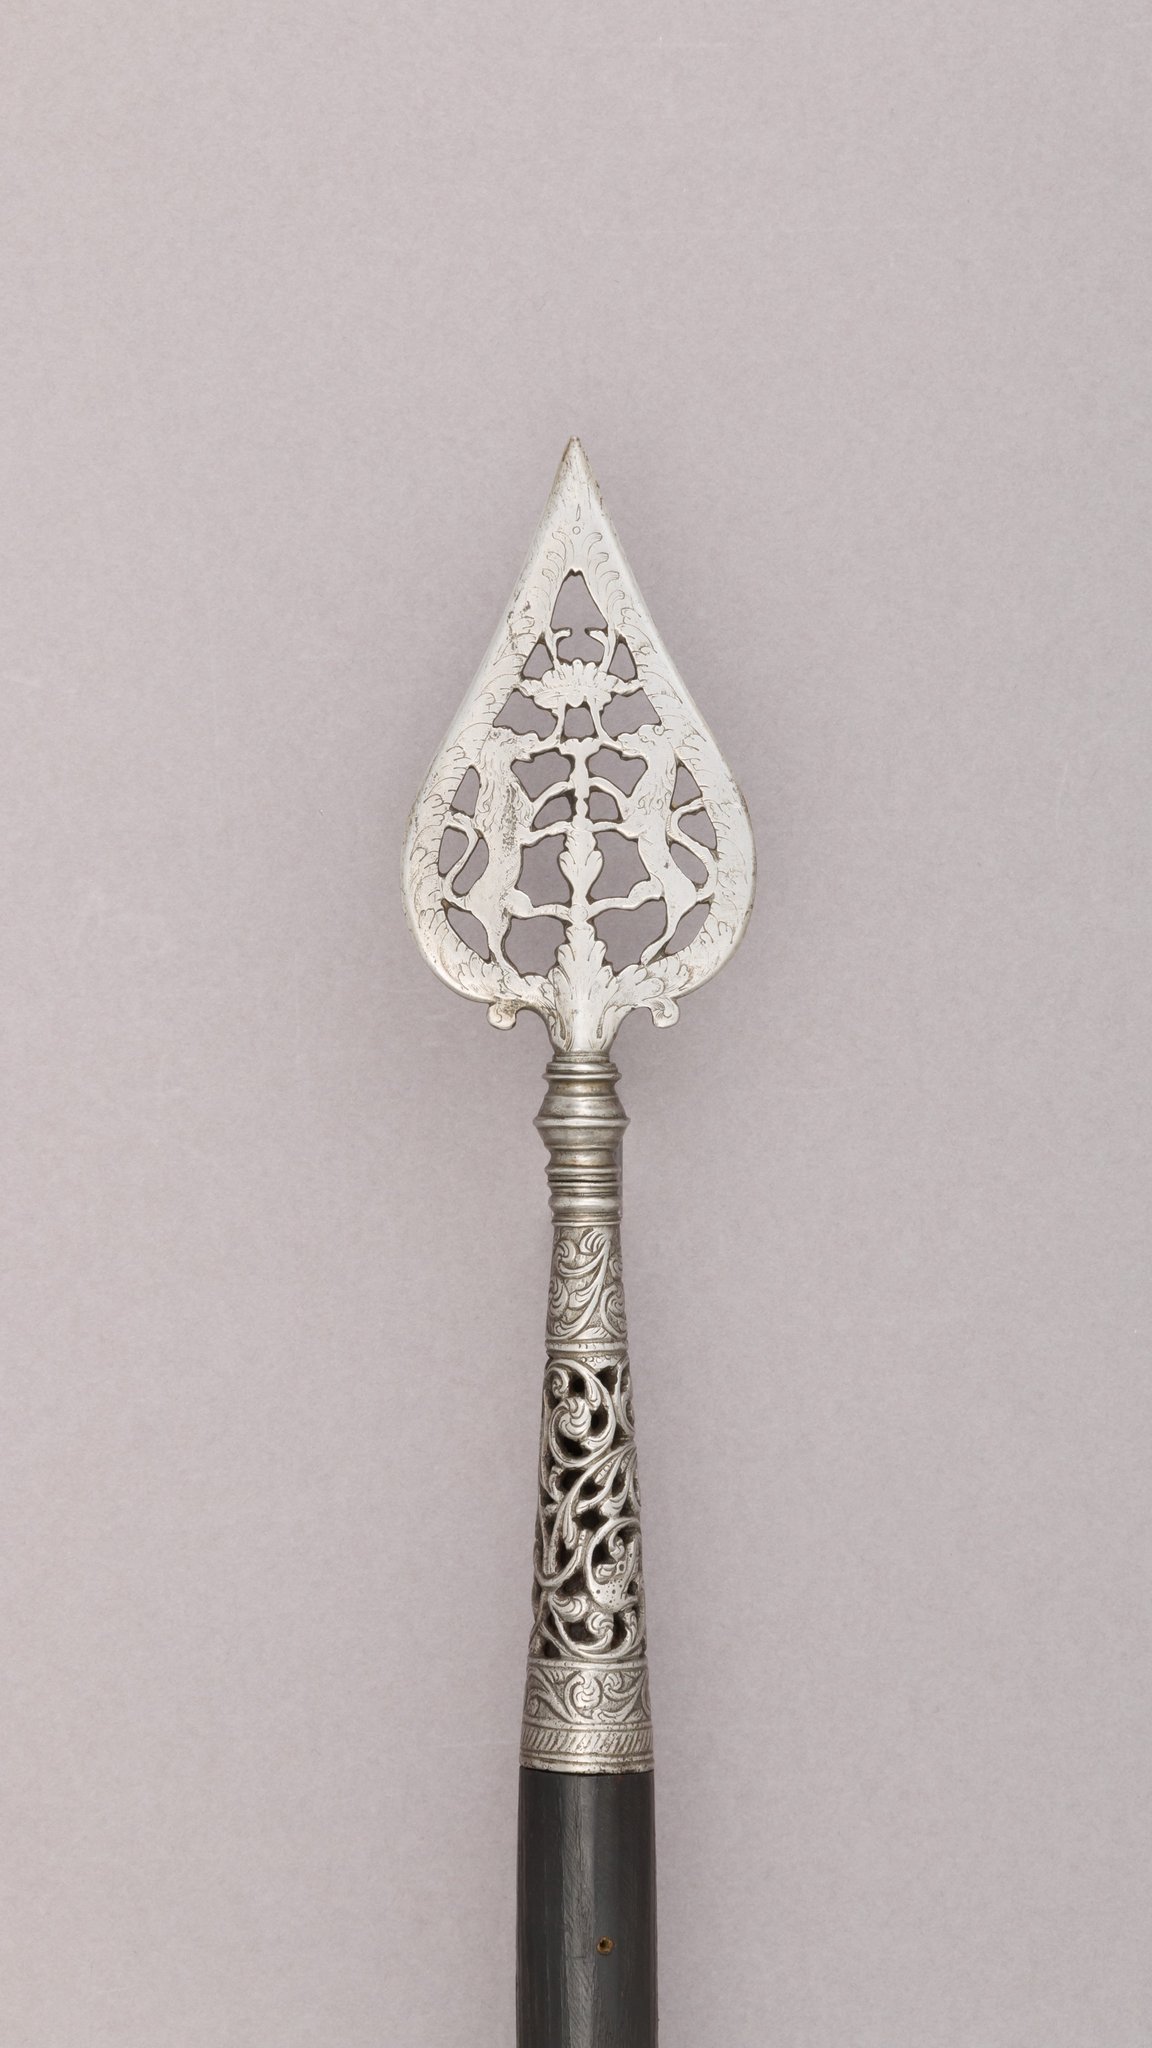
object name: spontoon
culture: french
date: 1701-1800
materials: steel, wood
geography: france